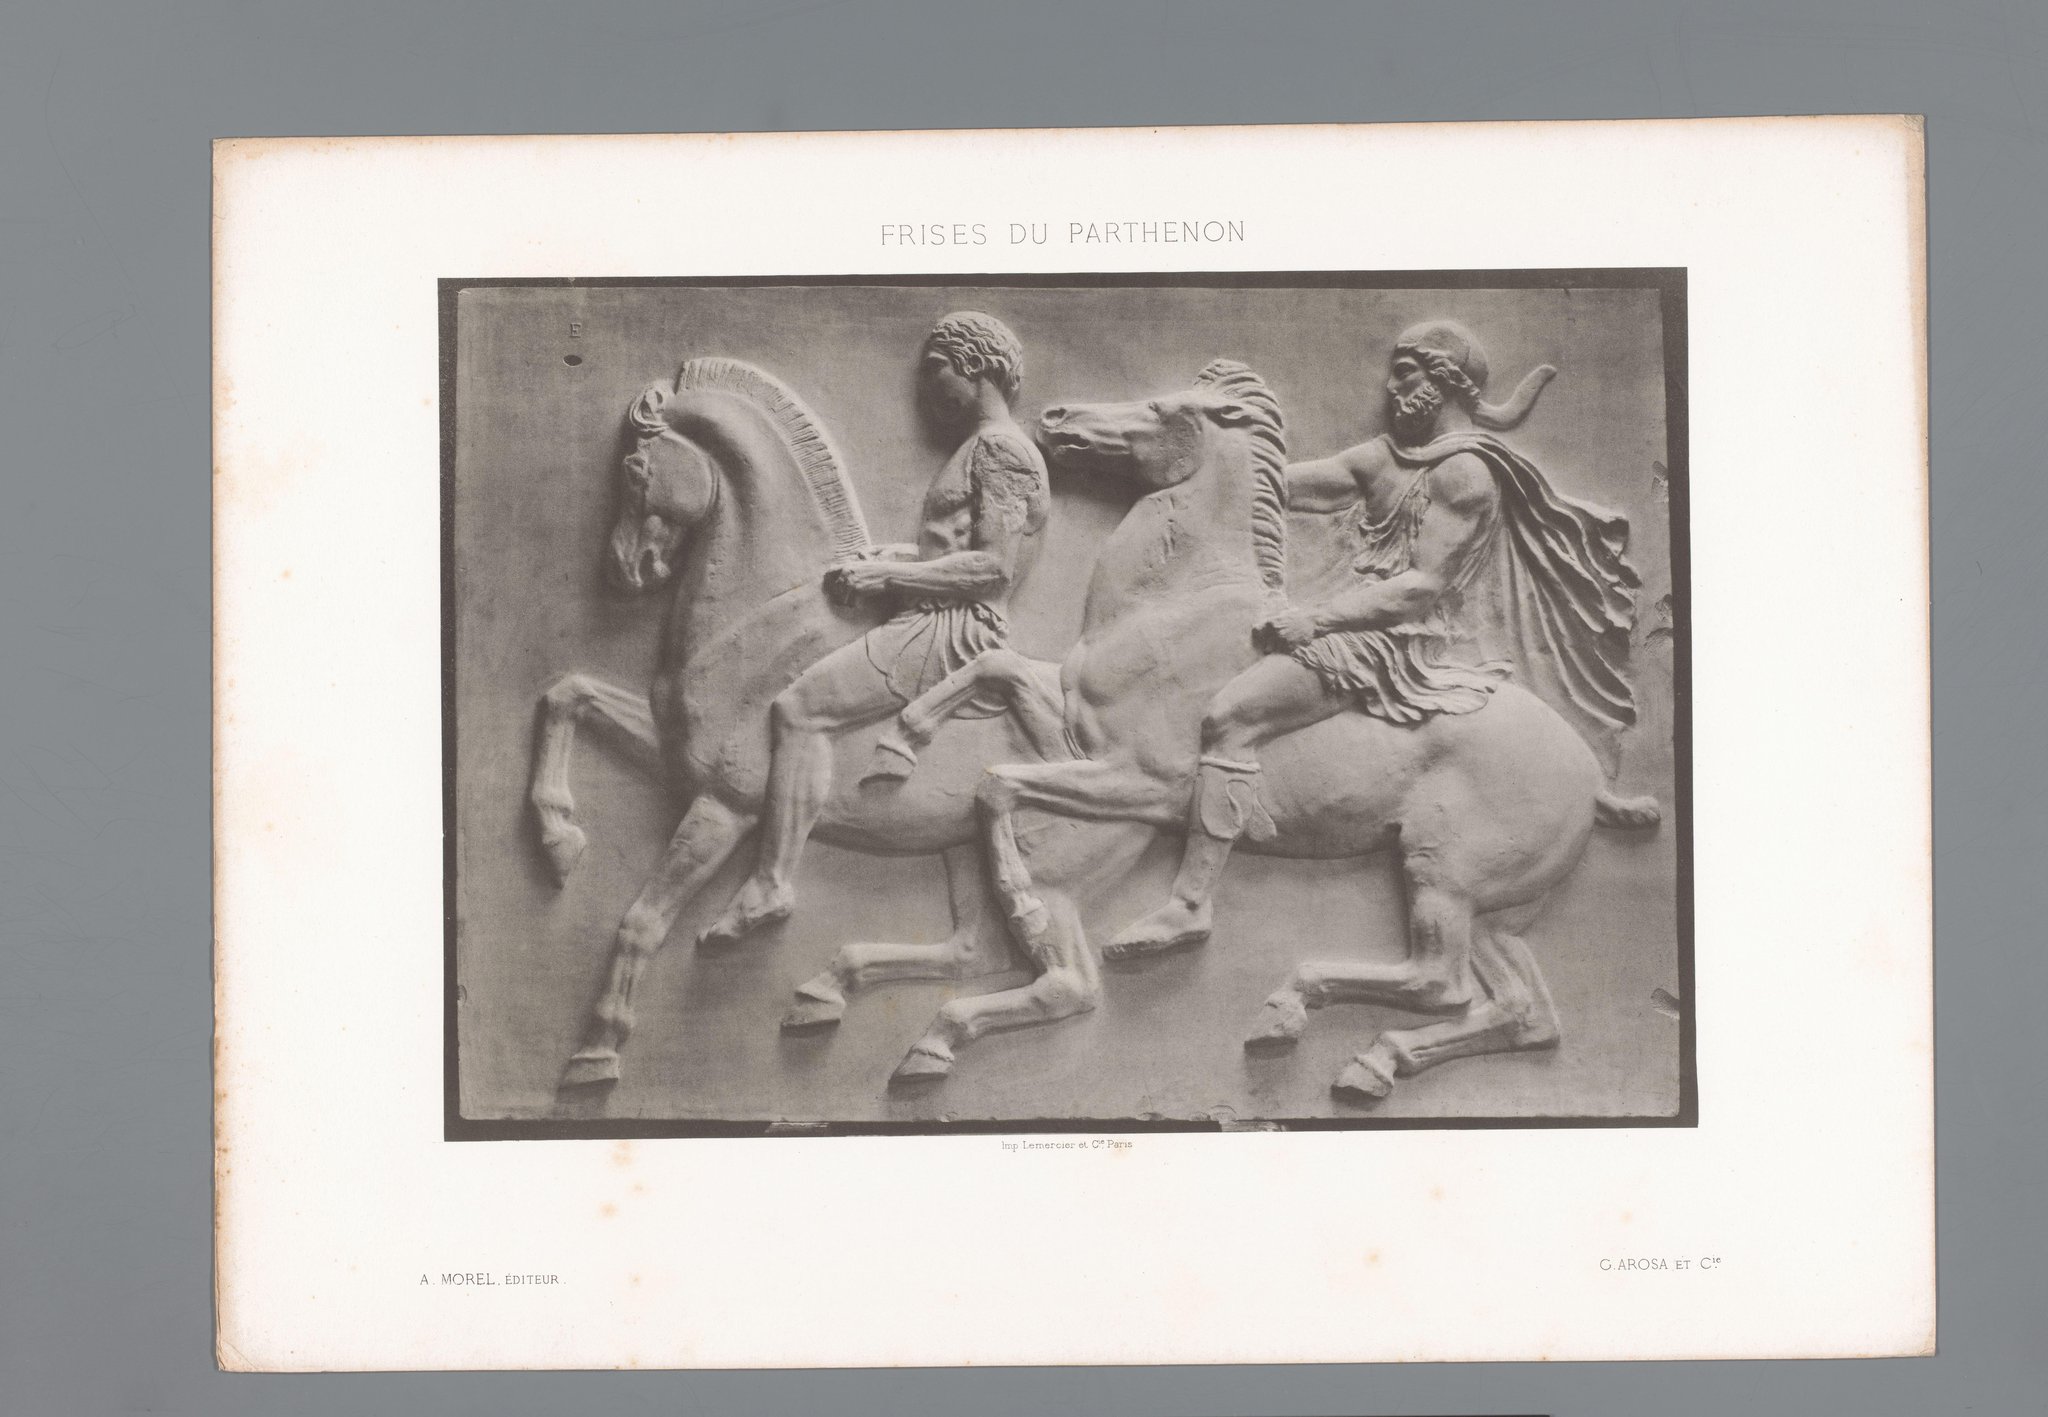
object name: photomechanical print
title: Frises du Parthenon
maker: a. morel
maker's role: publisher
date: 1863-1868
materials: paper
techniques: photograph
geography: paris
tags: riding a horse, ass, or mule; rider, horseman (+ two persons ~ traffic and transport), mouldings ~ architecture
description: Deze prent maakt deel uit van een omslag met 22 prenten en 3 tekstbladen.